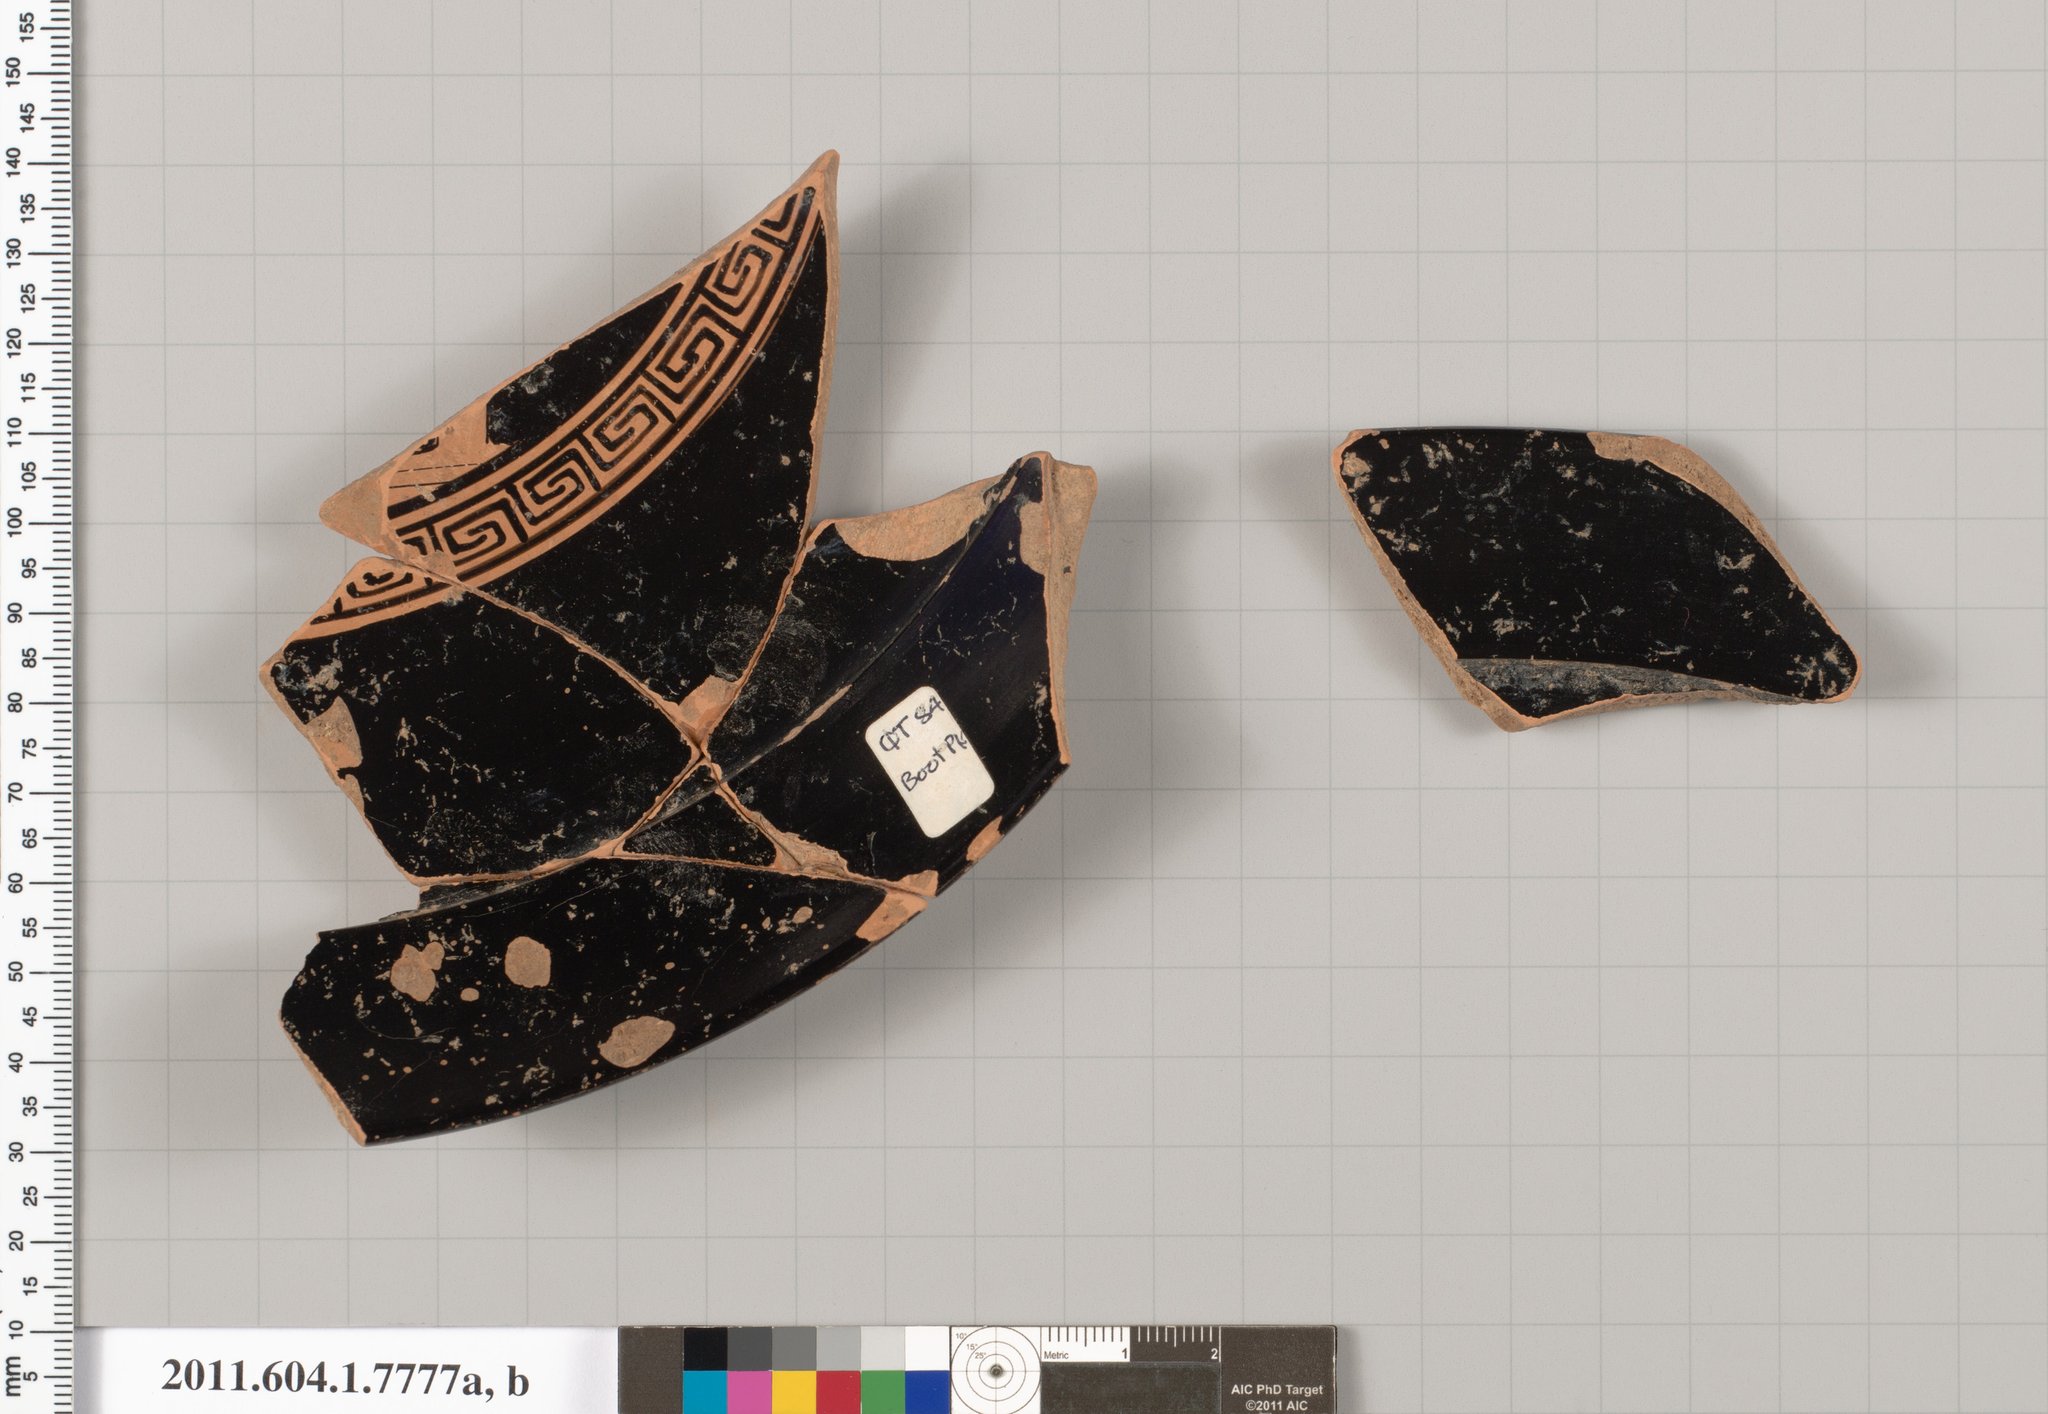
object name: kylix fragment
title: Terracotta rim fragments of a kylix (drinking cup)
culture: greek, attic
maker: boot painter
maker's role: artist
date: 480-470 BCE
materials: terracotta